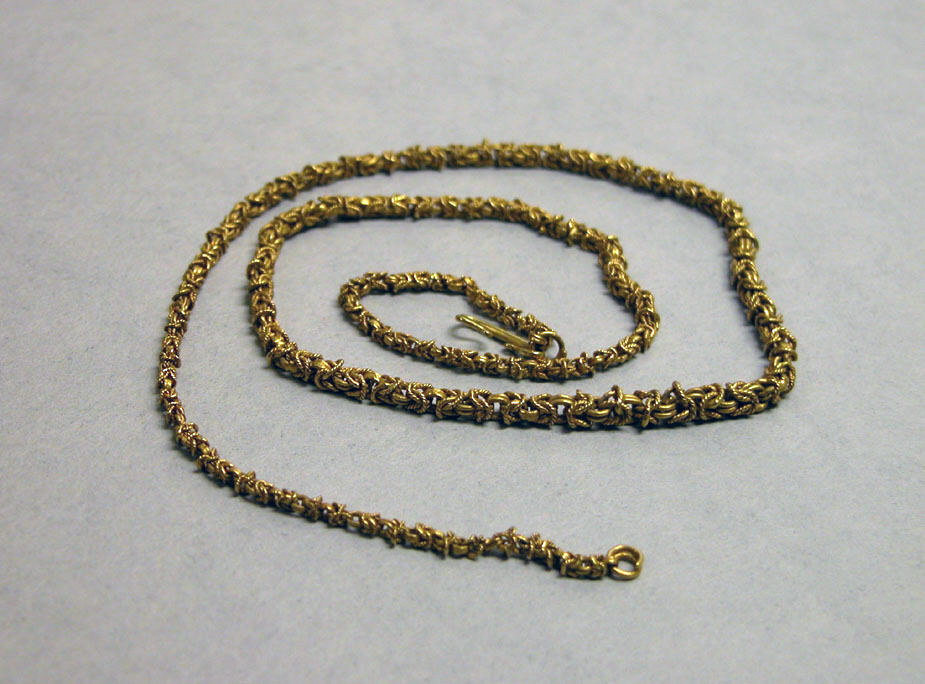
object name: chain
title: Twisted Wire Chain with Clasp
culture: indonesian, javanese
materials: gold